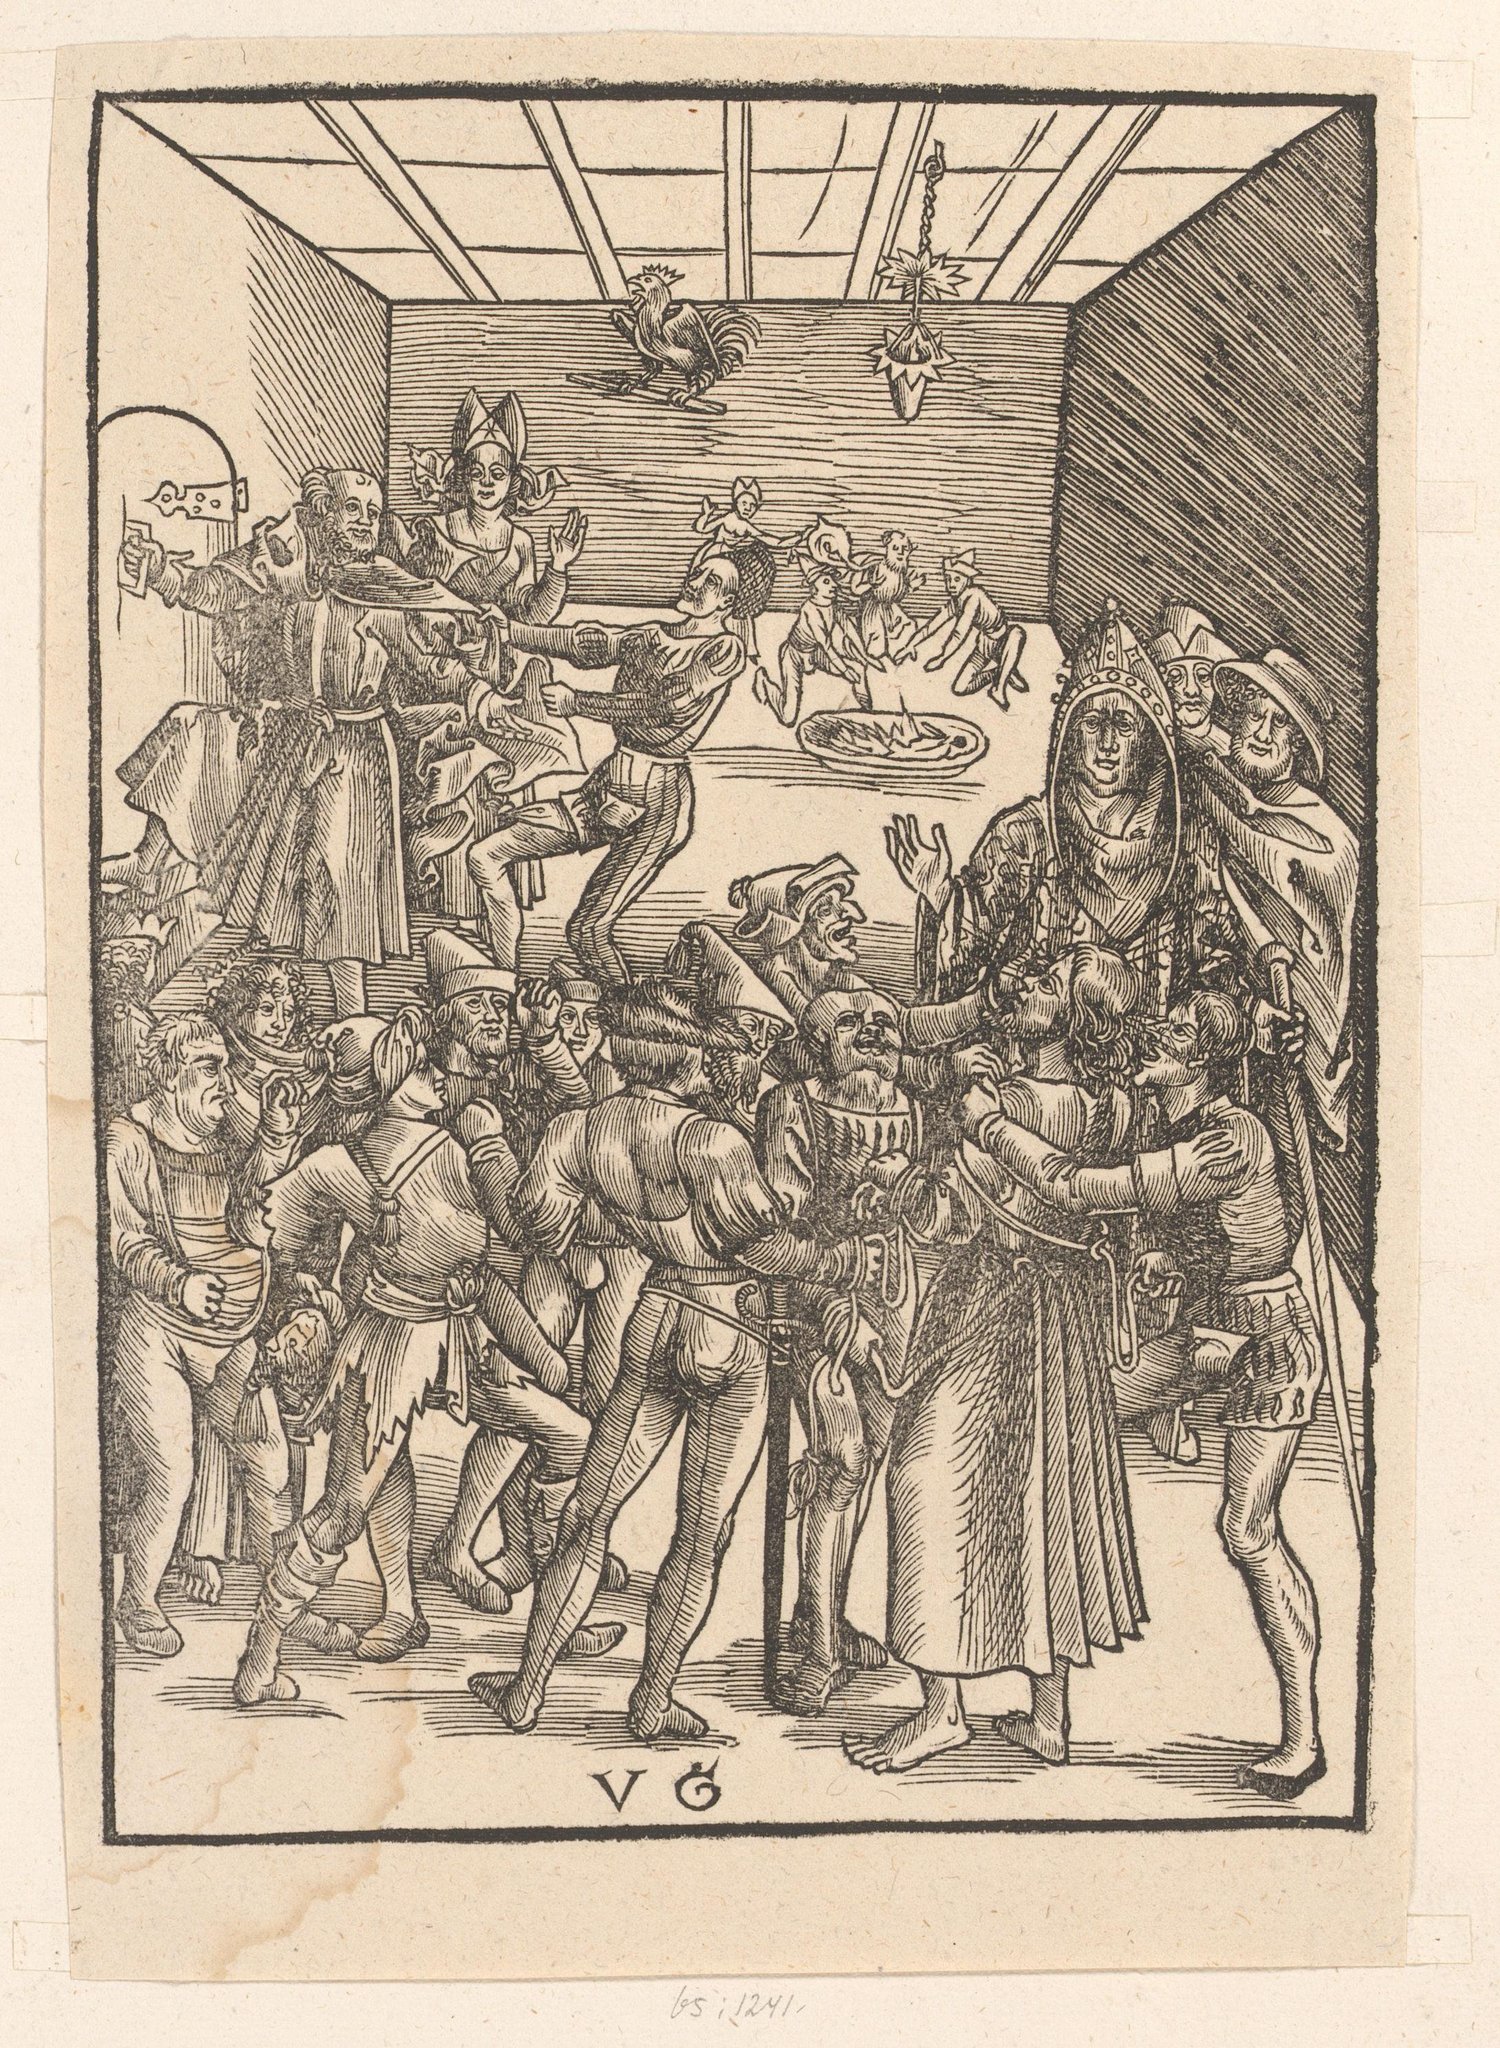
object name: album leaf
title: Leven en passie van Christus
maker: urs graf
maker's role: draughtsman, print maker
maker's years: 1485-1528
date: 1506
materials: paper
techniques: woodcut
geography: switzerland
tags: christ before annas (hanna); maybe a soldier about to strike christ (john 18:13, 18:19-24), peter denies christ, usually before a girl-servant and some soldiers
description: Op de voorgrond Christus die door soldaten voor Annas wordt geleid. Daarachter Petrus die tegen een dienstmeisje en een man zegt dat hij Christus niet kent, terwijl hij de deur probeert te openen. In het midden de haan die drie keer kraait. Prent maakt deel uit van een album.